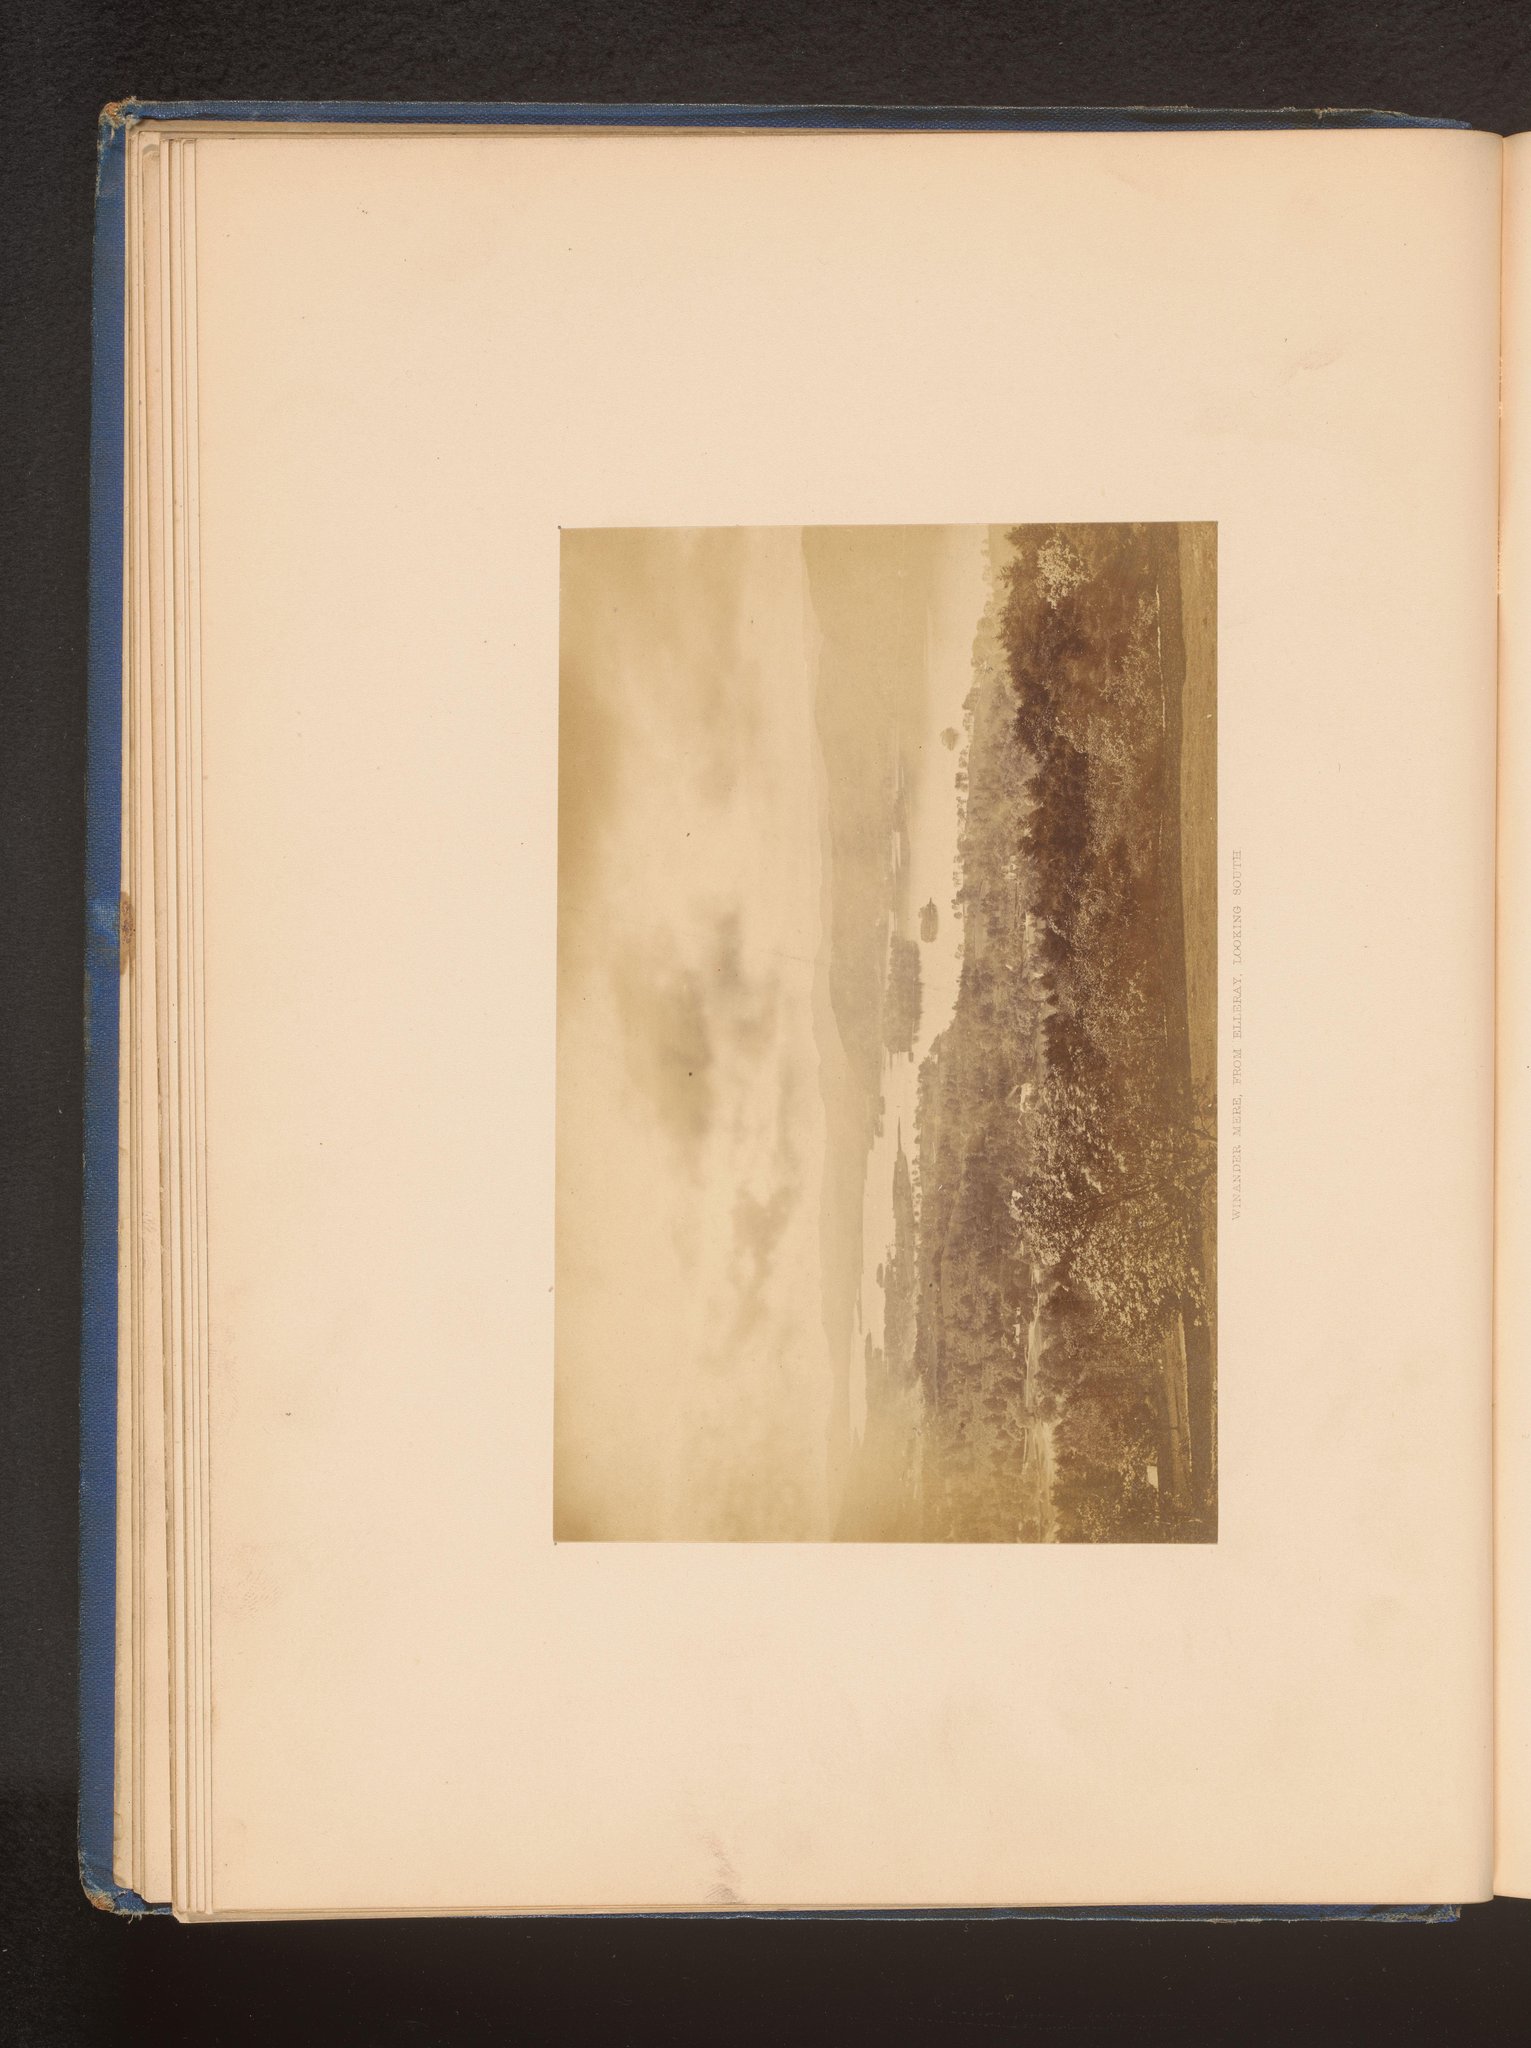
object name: page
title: Gezicht over het Windermere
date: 1857-1867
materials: photographic support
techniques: albumen print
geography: lake district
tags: lake